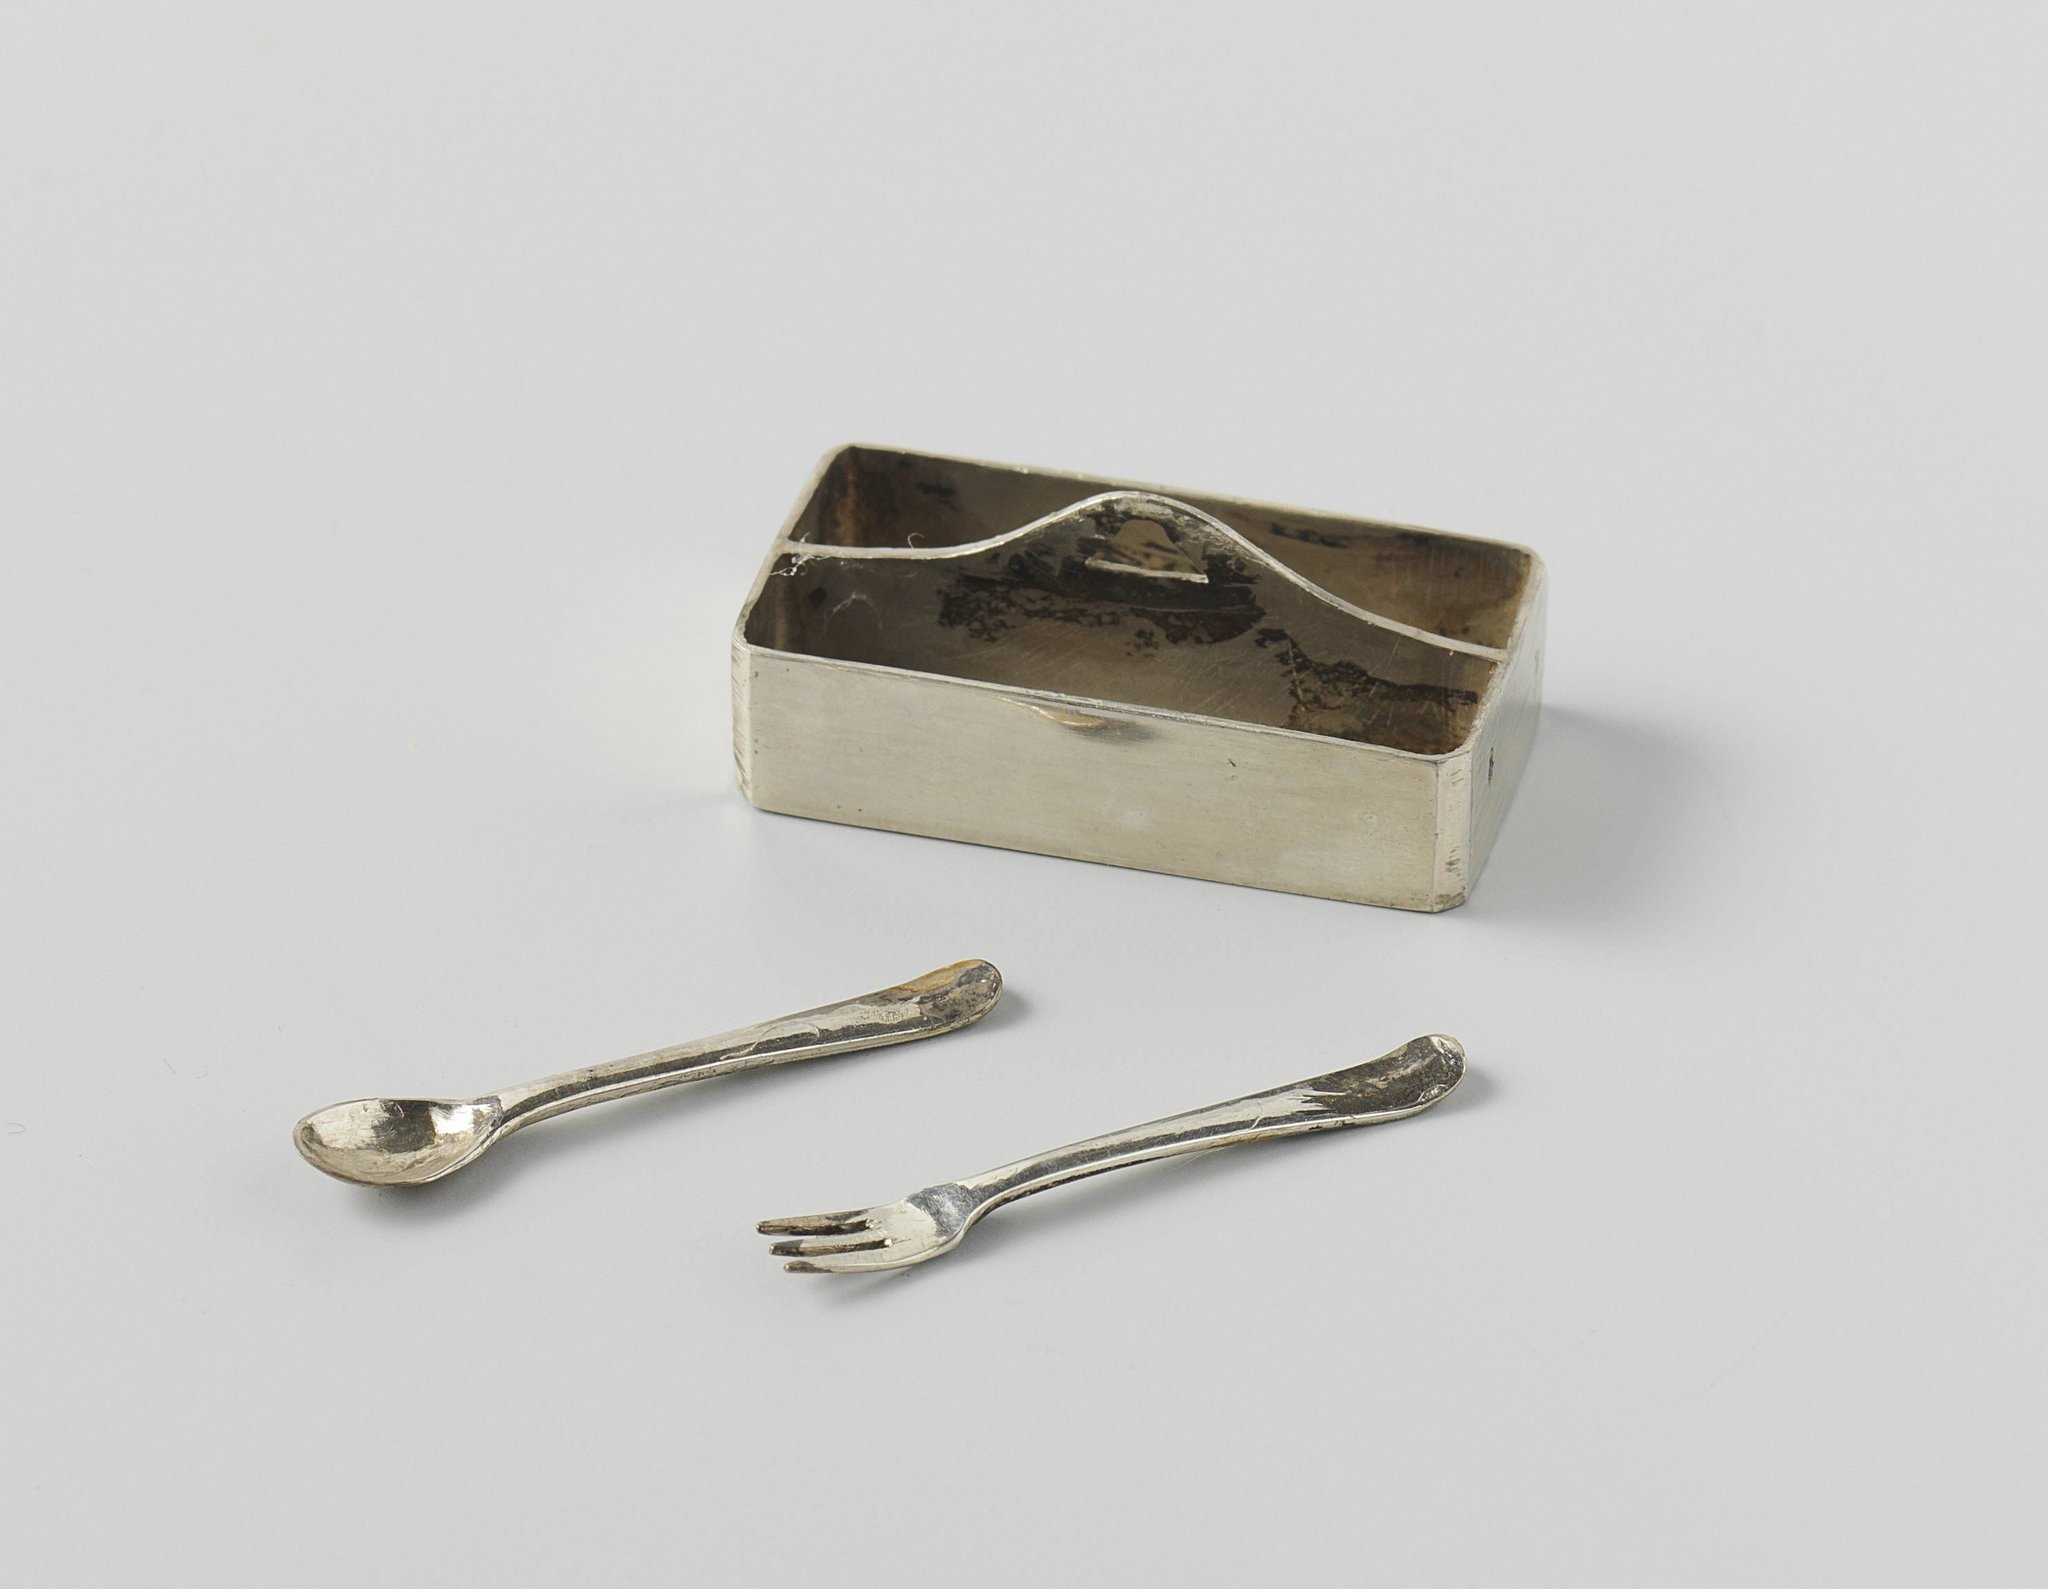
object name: miniature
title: Vork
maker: b. dellemijn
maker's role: silversmith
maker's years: -1917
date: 1842-1898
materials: silver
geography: doesburg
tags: fork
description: Vork met drie tanden en een platte steel. De vork hoort samen met een lepel (BK-NM-11177-150-b) in een bestekbak (BK-NM-11177-150-a). De vork is niet gemerkt.